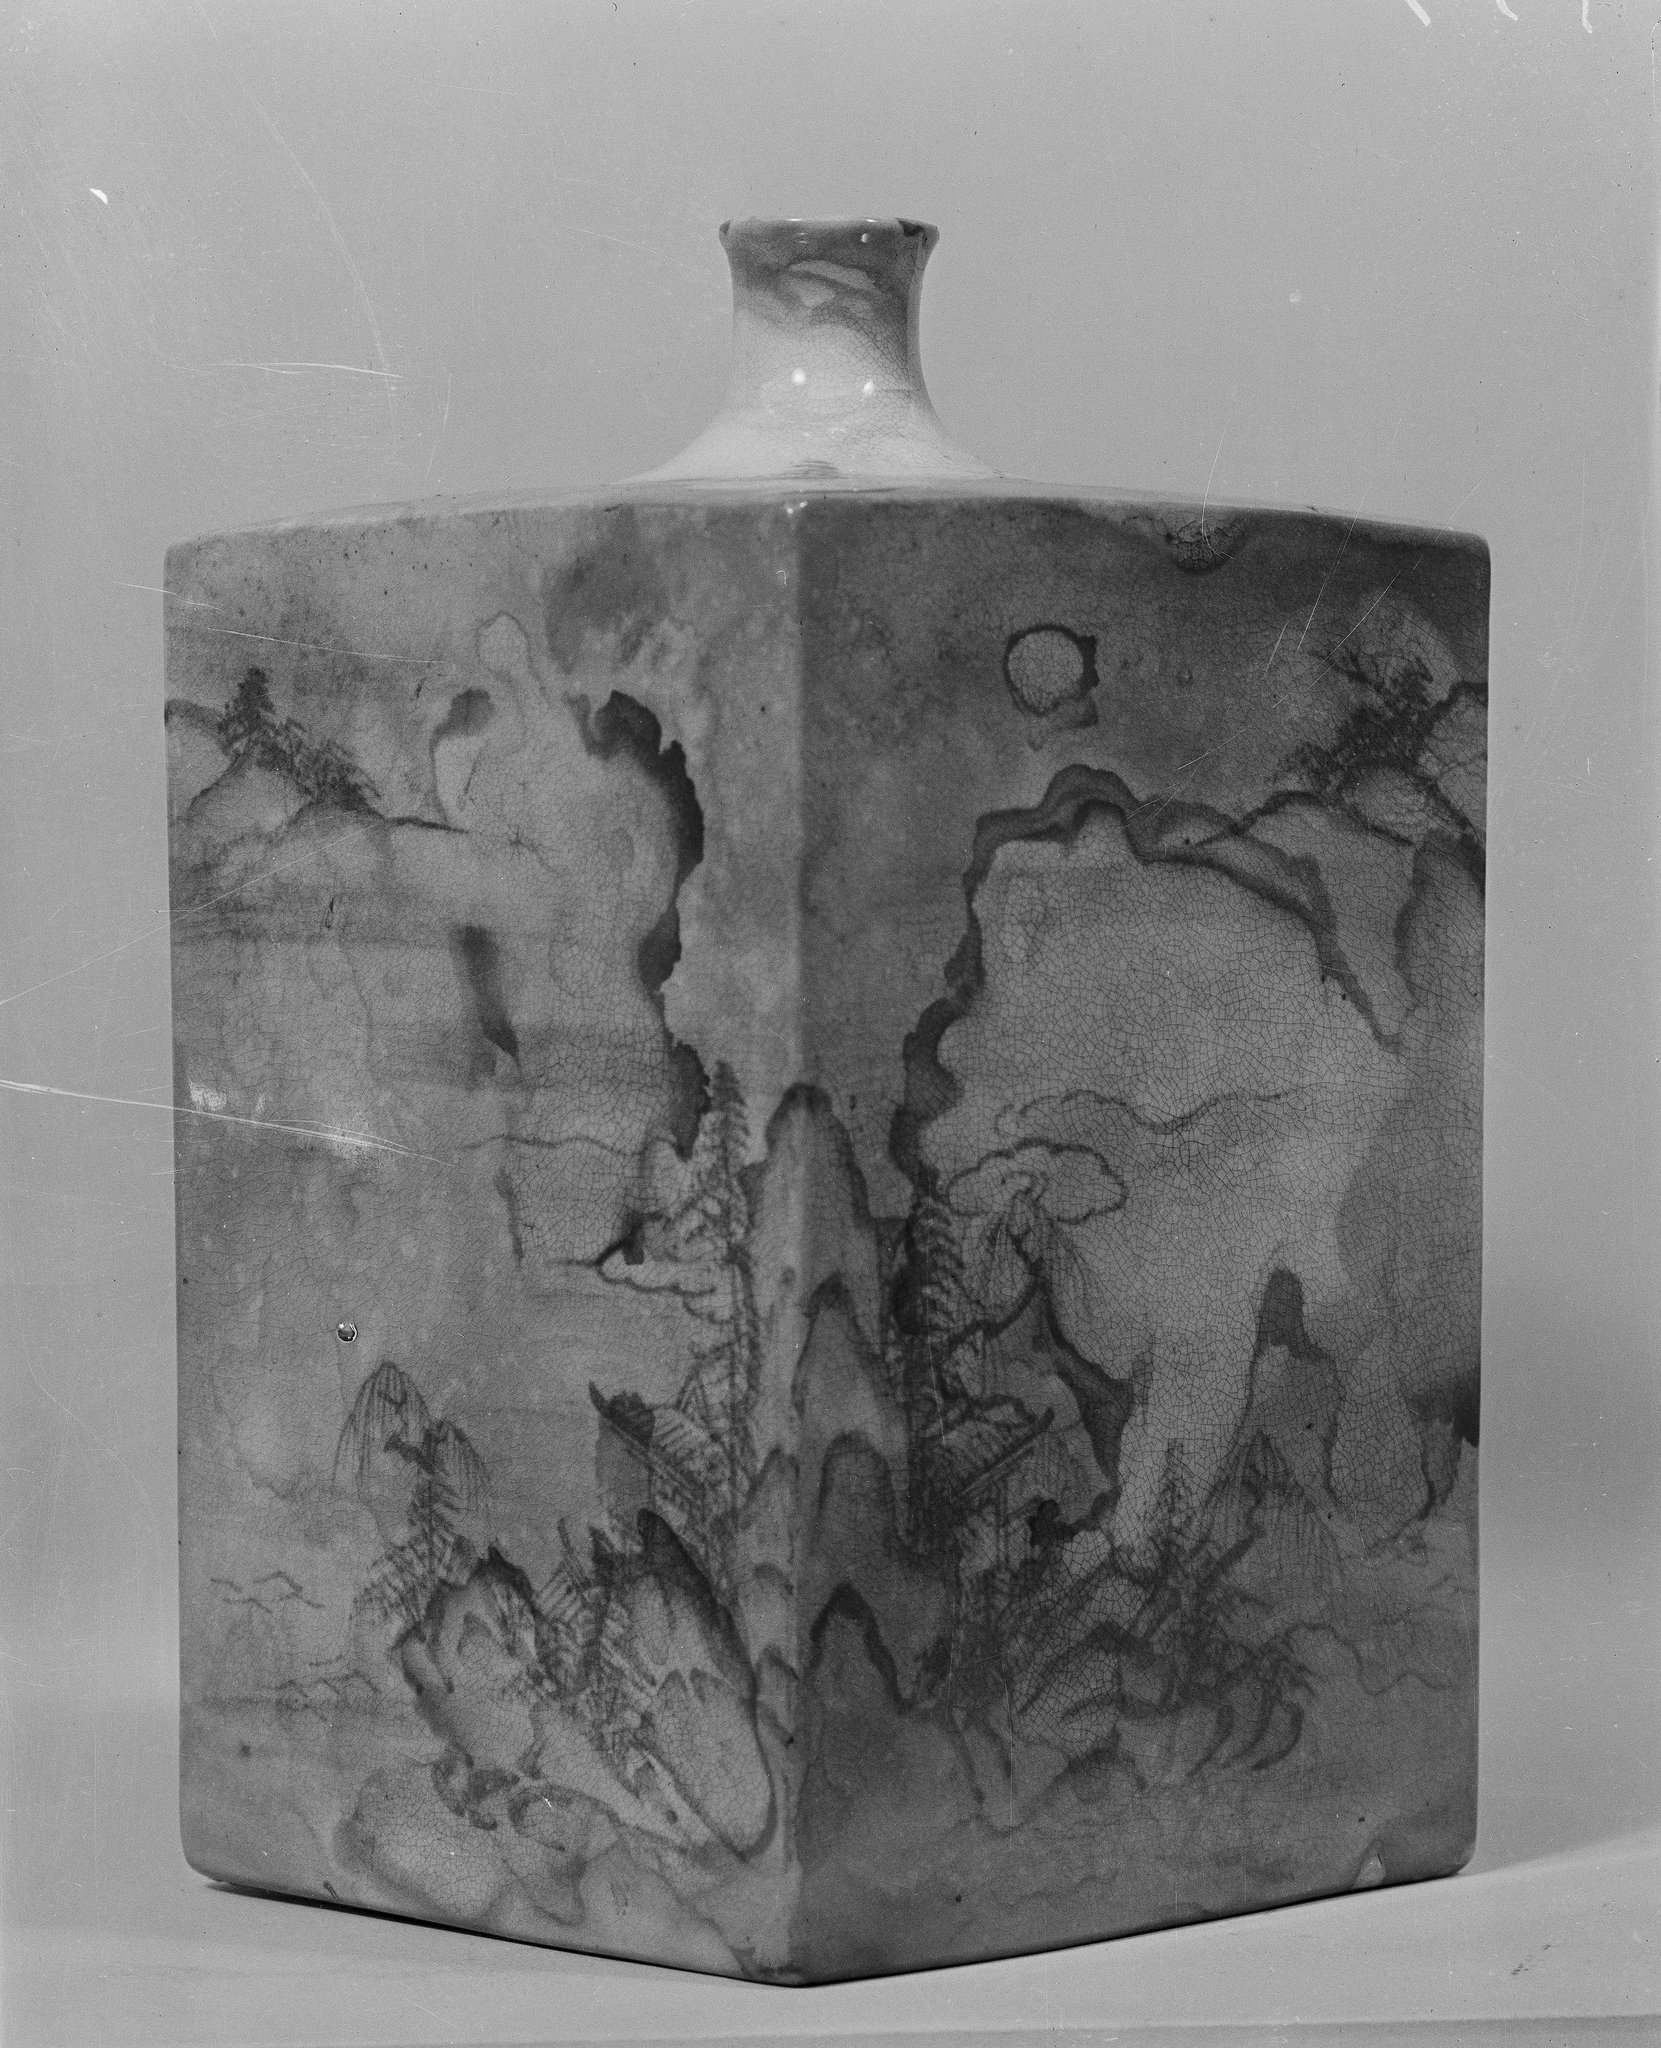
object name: wine bottle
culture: japanese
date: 1750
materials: clay, glaze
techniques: underglaze